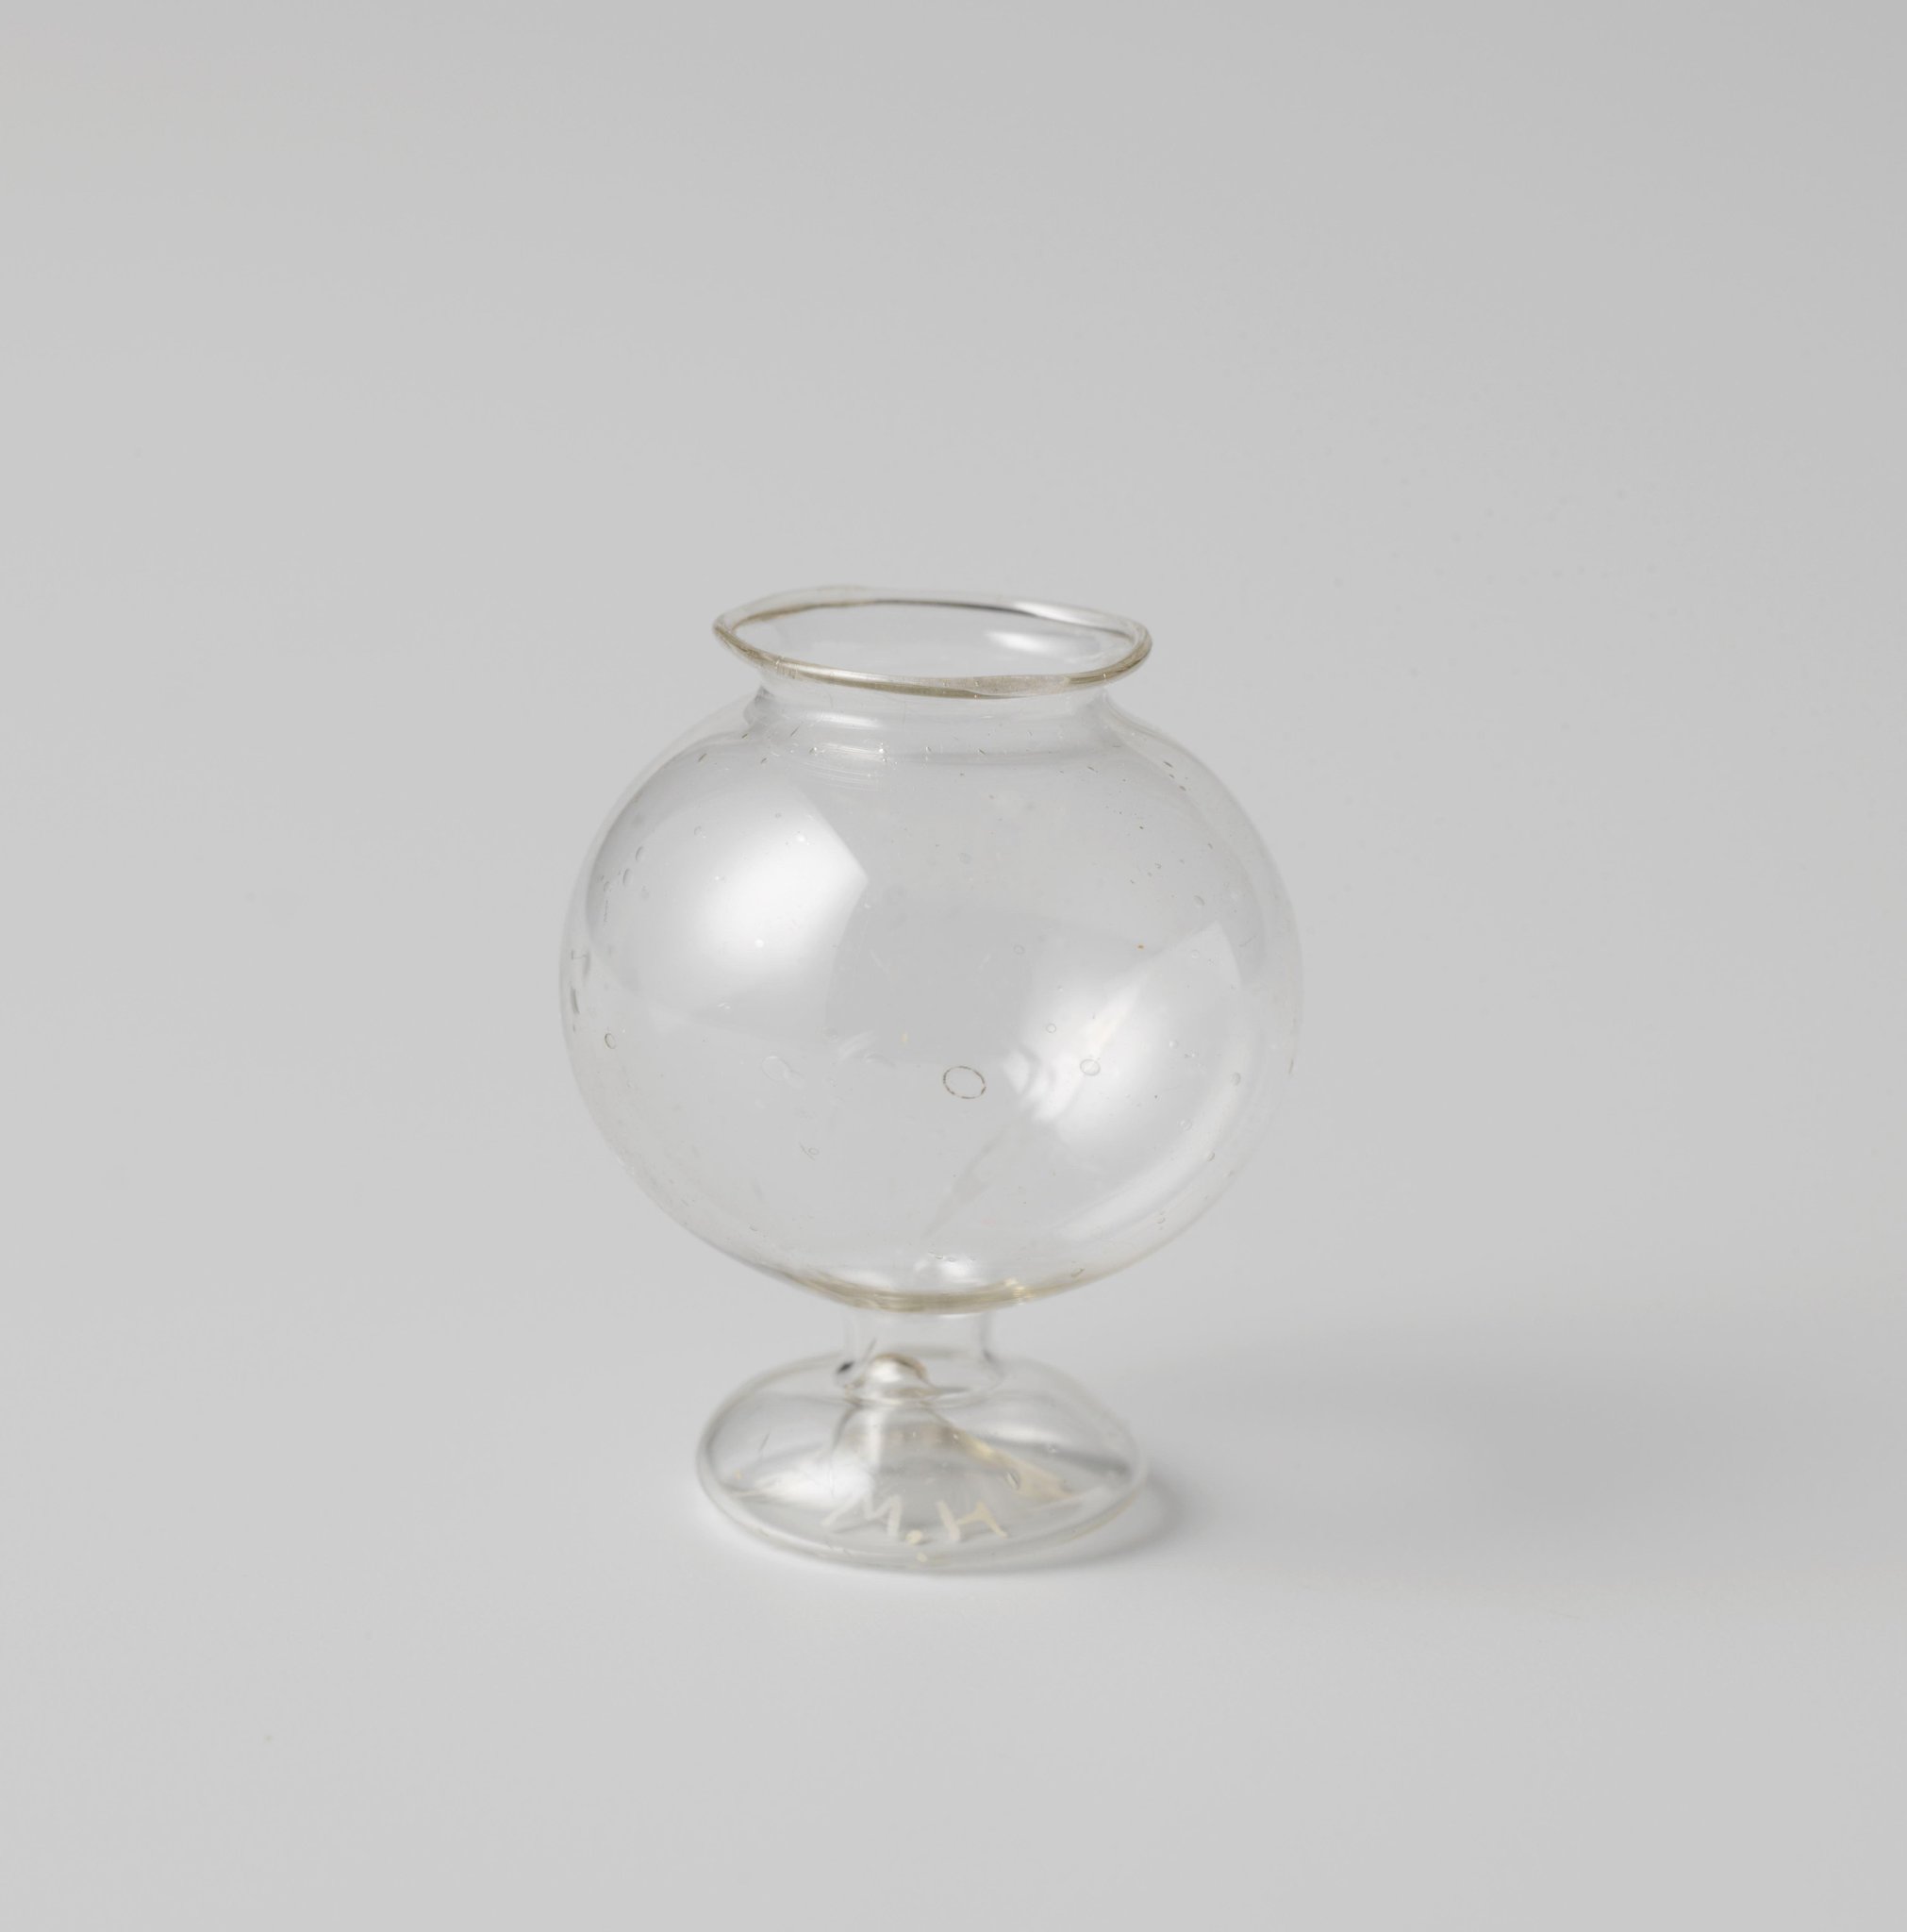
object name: drinking glass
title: Glas, mogelijk voorstellend een waterlens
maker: Anonymous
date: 1675-1699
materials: glass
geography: haarlem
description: Glas, helder kleurloos, mogelijk voorstellend een waterlens; grote bolle cuppa met nauwe naar buiten omgeslagen rand, op naar binnen gestoken holle voet en op korte stam. Mogelijk een waterlens.